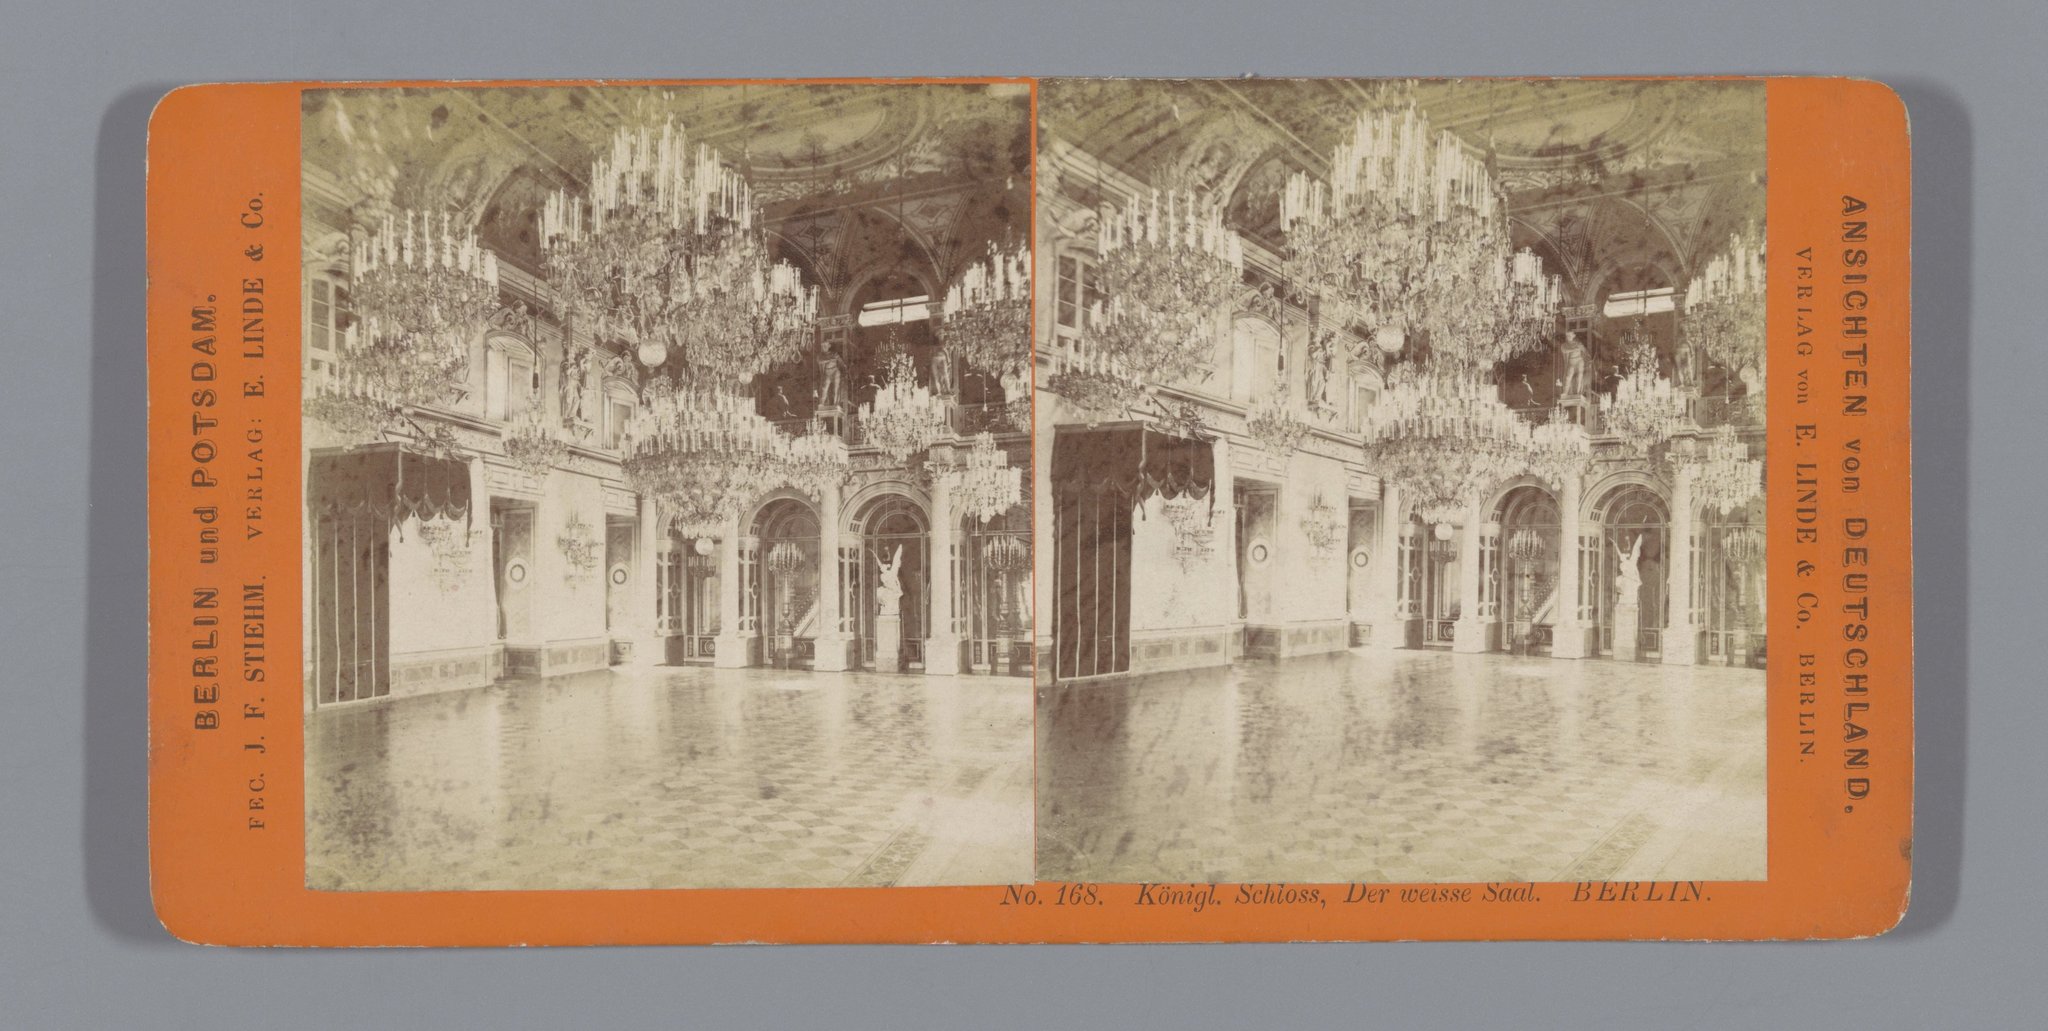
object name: stereograph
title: Königl. Schloss, Der weisse Saal. Berlin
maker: johann friedrich stiehm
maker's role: fotograaf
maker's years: 1826-1902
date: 1868-1870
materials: cardboard, paper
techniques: albumen print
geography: berlin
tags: palace - aa - civic architecture: inside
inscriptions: number: ‘No. 168.’